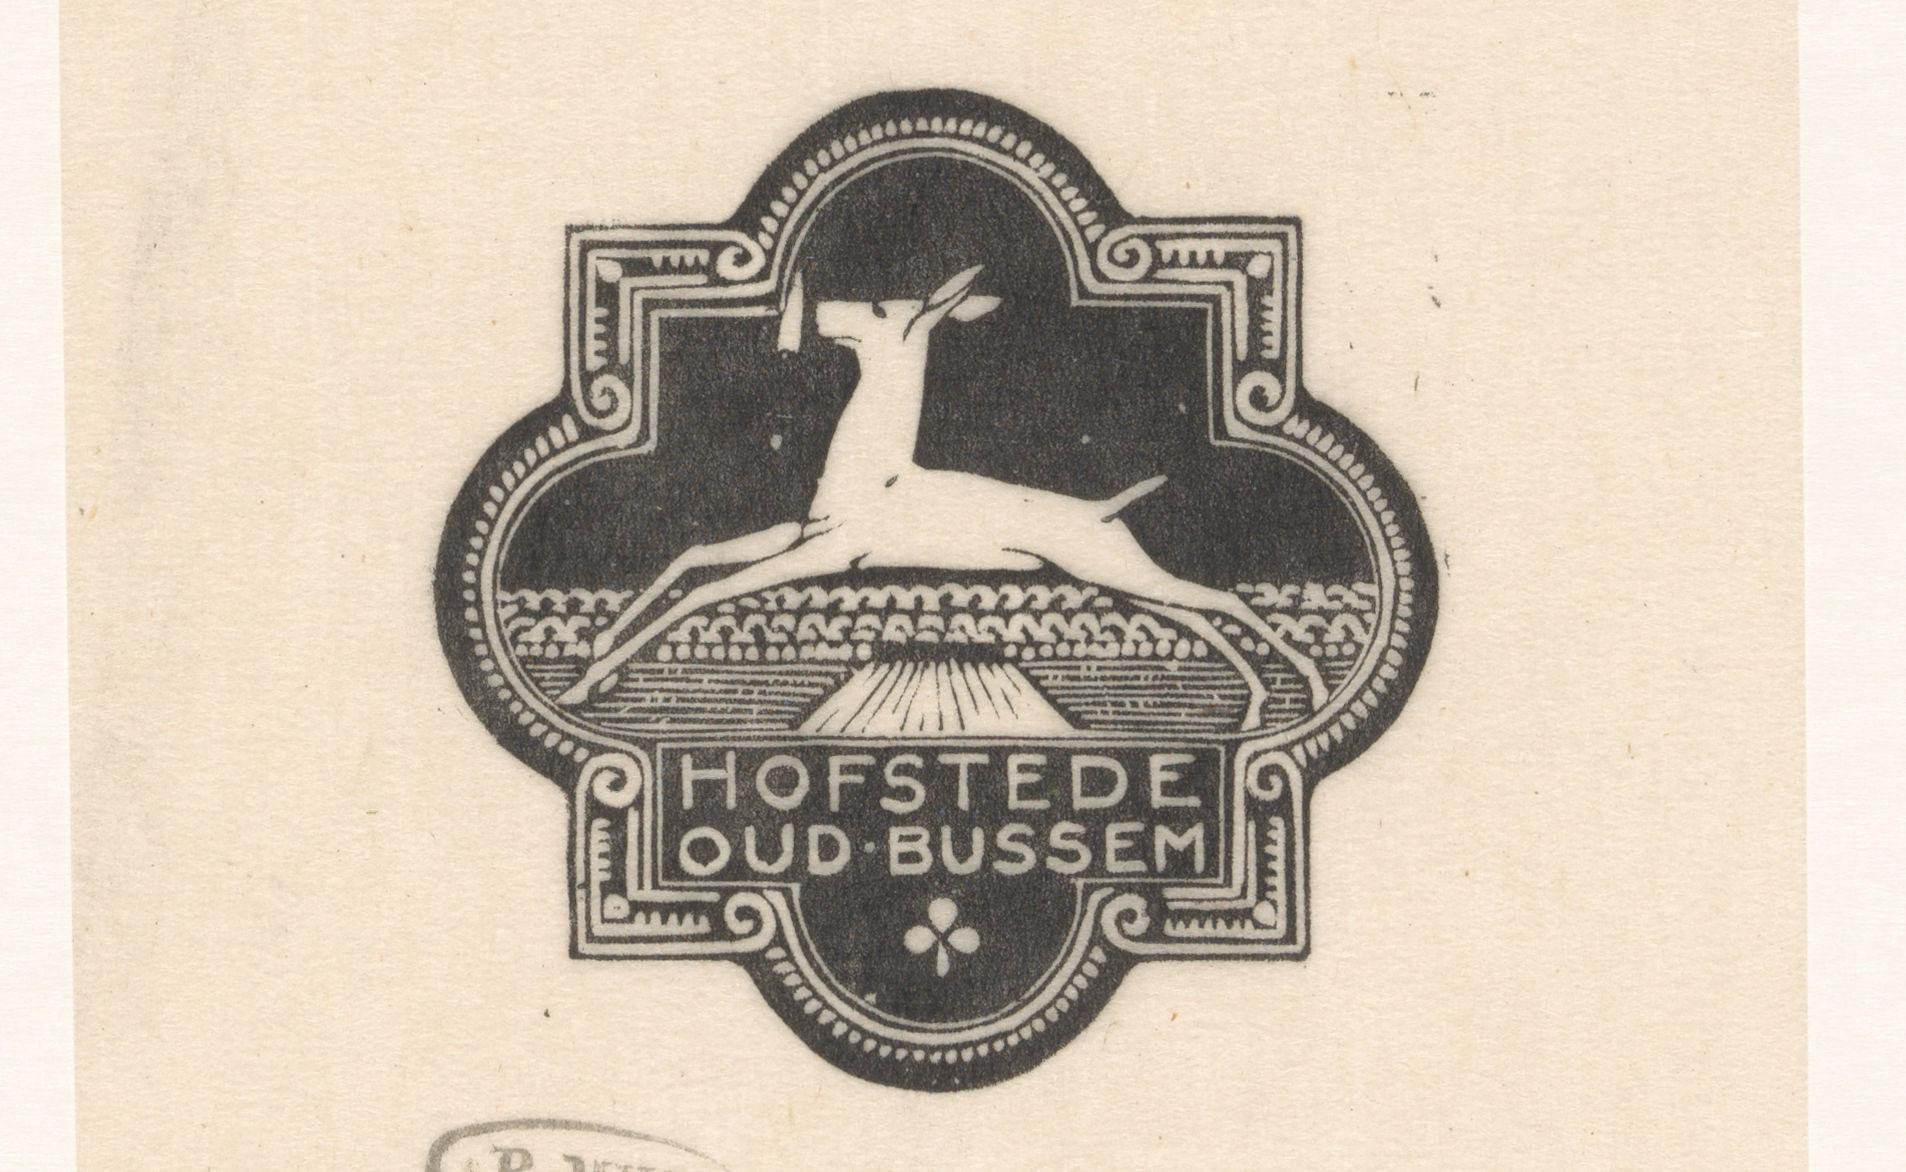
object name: print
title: Stempelontwerp Hofstede Oud-Bussem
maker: karel petrus cornelis de bazel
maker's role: draughtsman, print maker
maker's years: 1869-1923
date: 1903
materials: paper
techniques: woodcut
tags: hoofed animals: deer, seal, stamp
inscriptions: collector's mark: Lugt 2228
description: Karel De Bazel was de architect van het gebouwencomplex Hofstede Oud-Bussem.